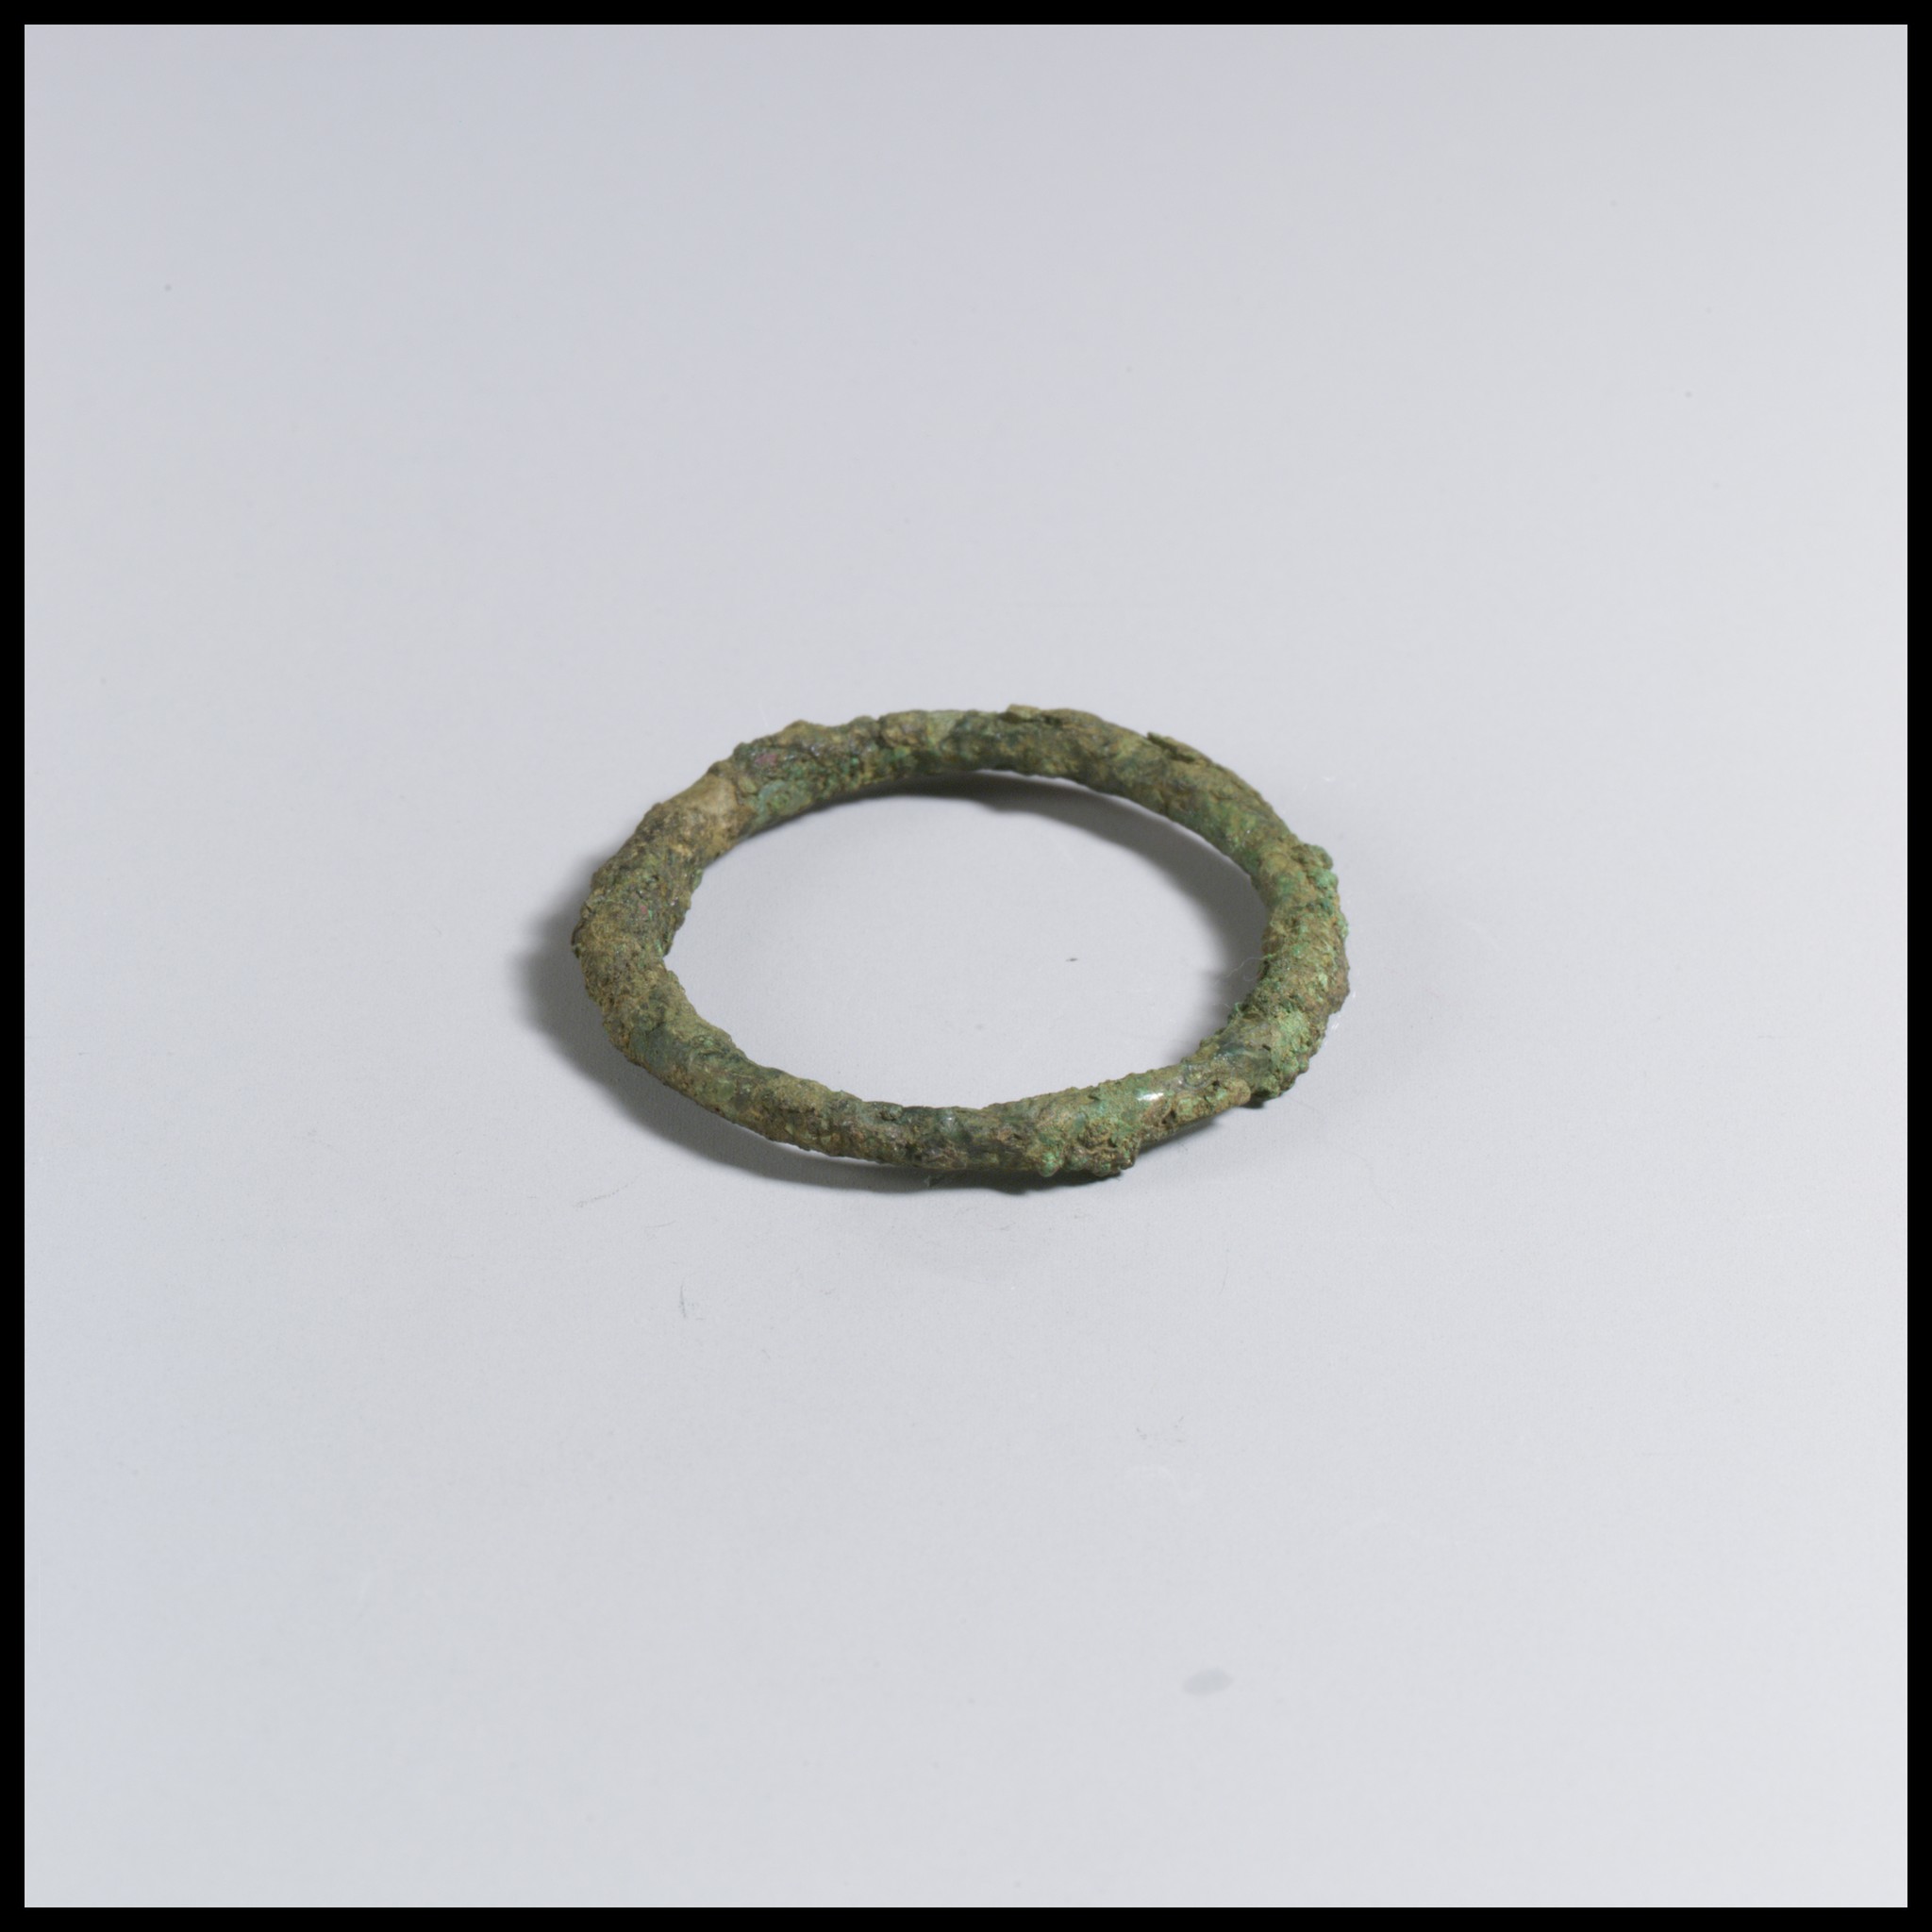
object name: ring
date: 7000 BCE-330 CE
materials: bronze